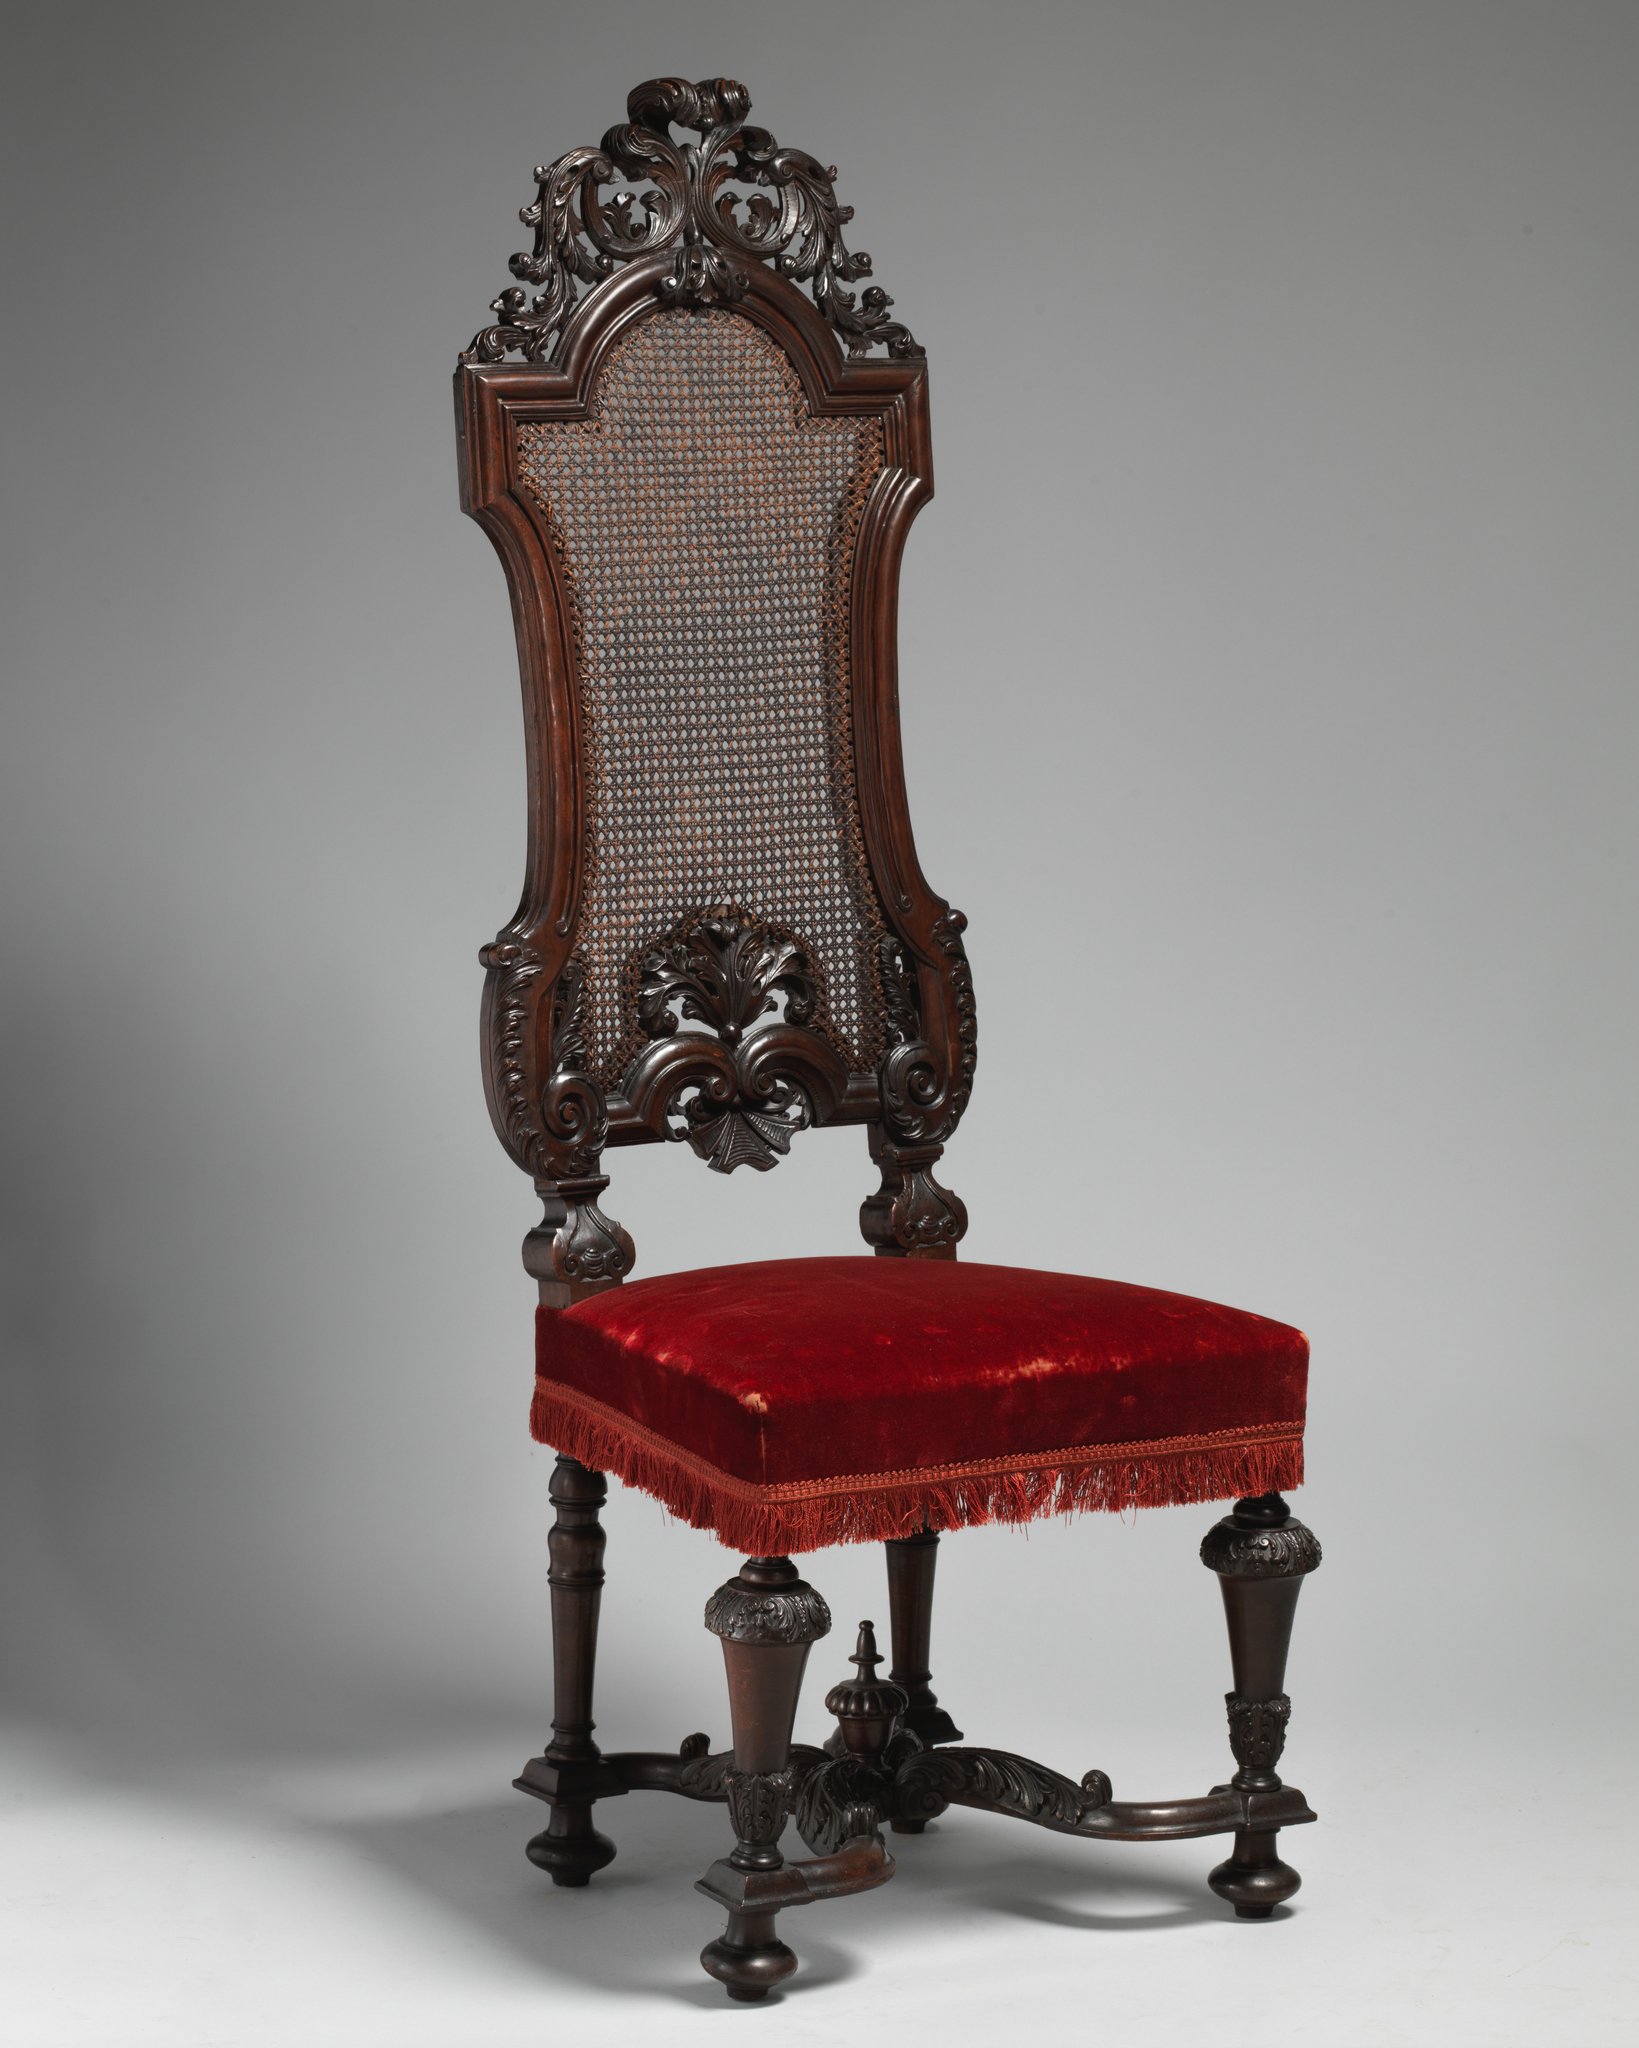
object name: chair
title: Chair (one of a set of six)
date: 1695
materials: velvet, wood